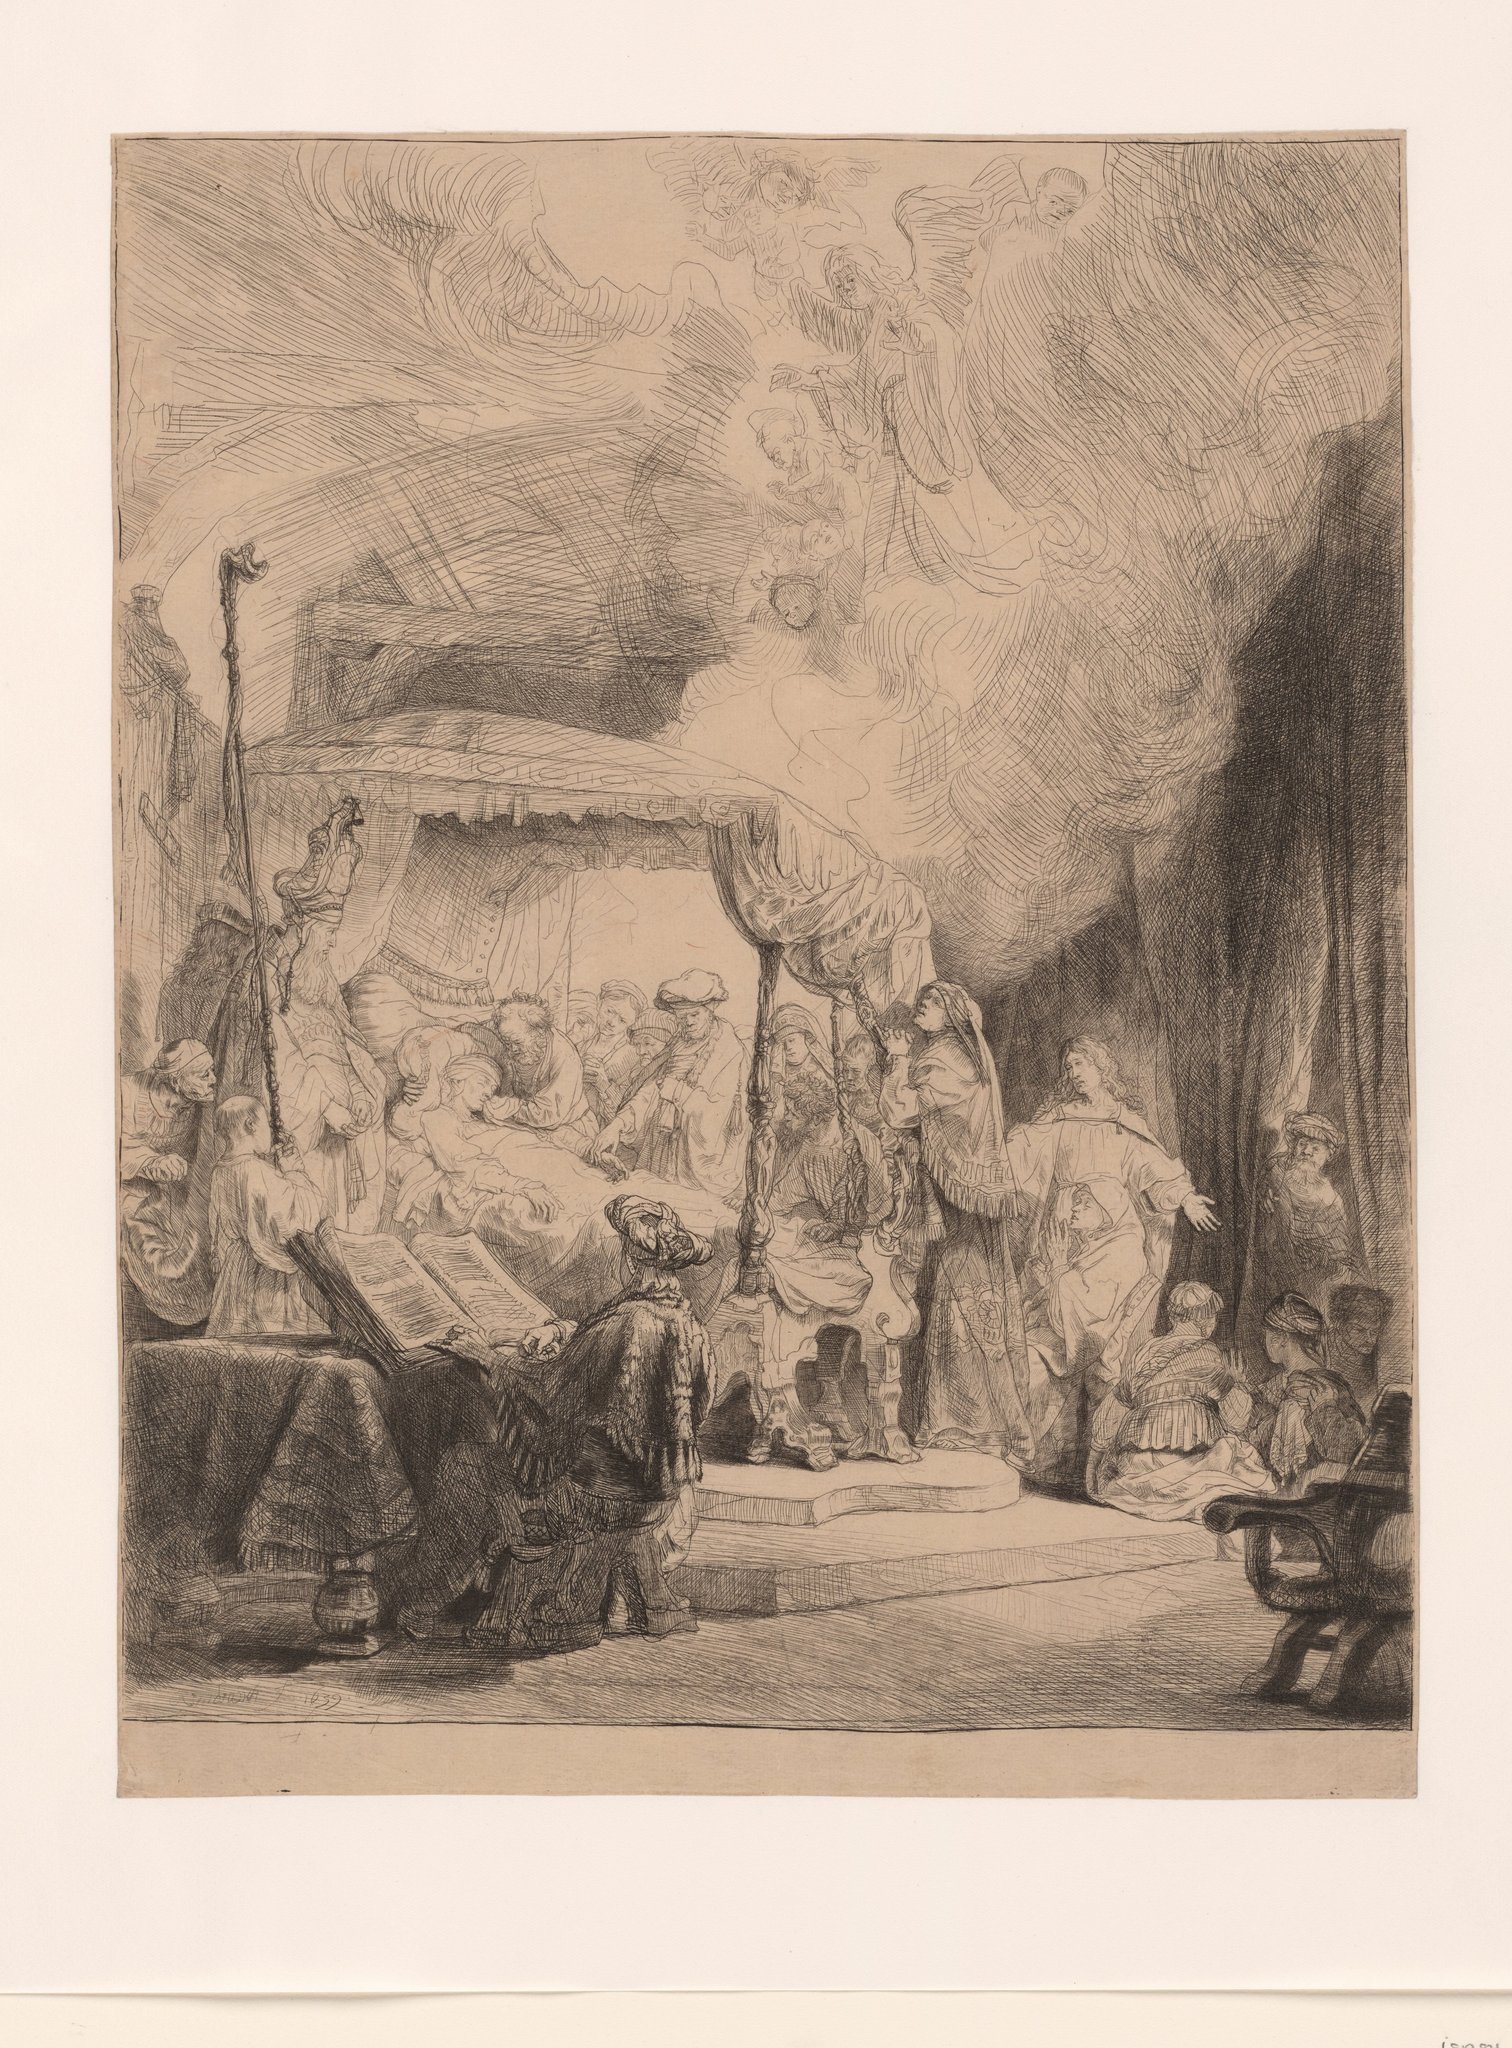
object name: print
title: The death of the Virgin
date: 1639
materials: paper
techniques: drypoint, etching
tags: the dormition: mary on her deathbed; the apostles are gathered around her (john the evangelist may be shown sleeping or dreaming)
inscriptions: collector's mark: Lugt 2228, signature and date: ‘Rembrandt f 1639’, collector's mark: Lugt 807, collector's mark: Lugt 33